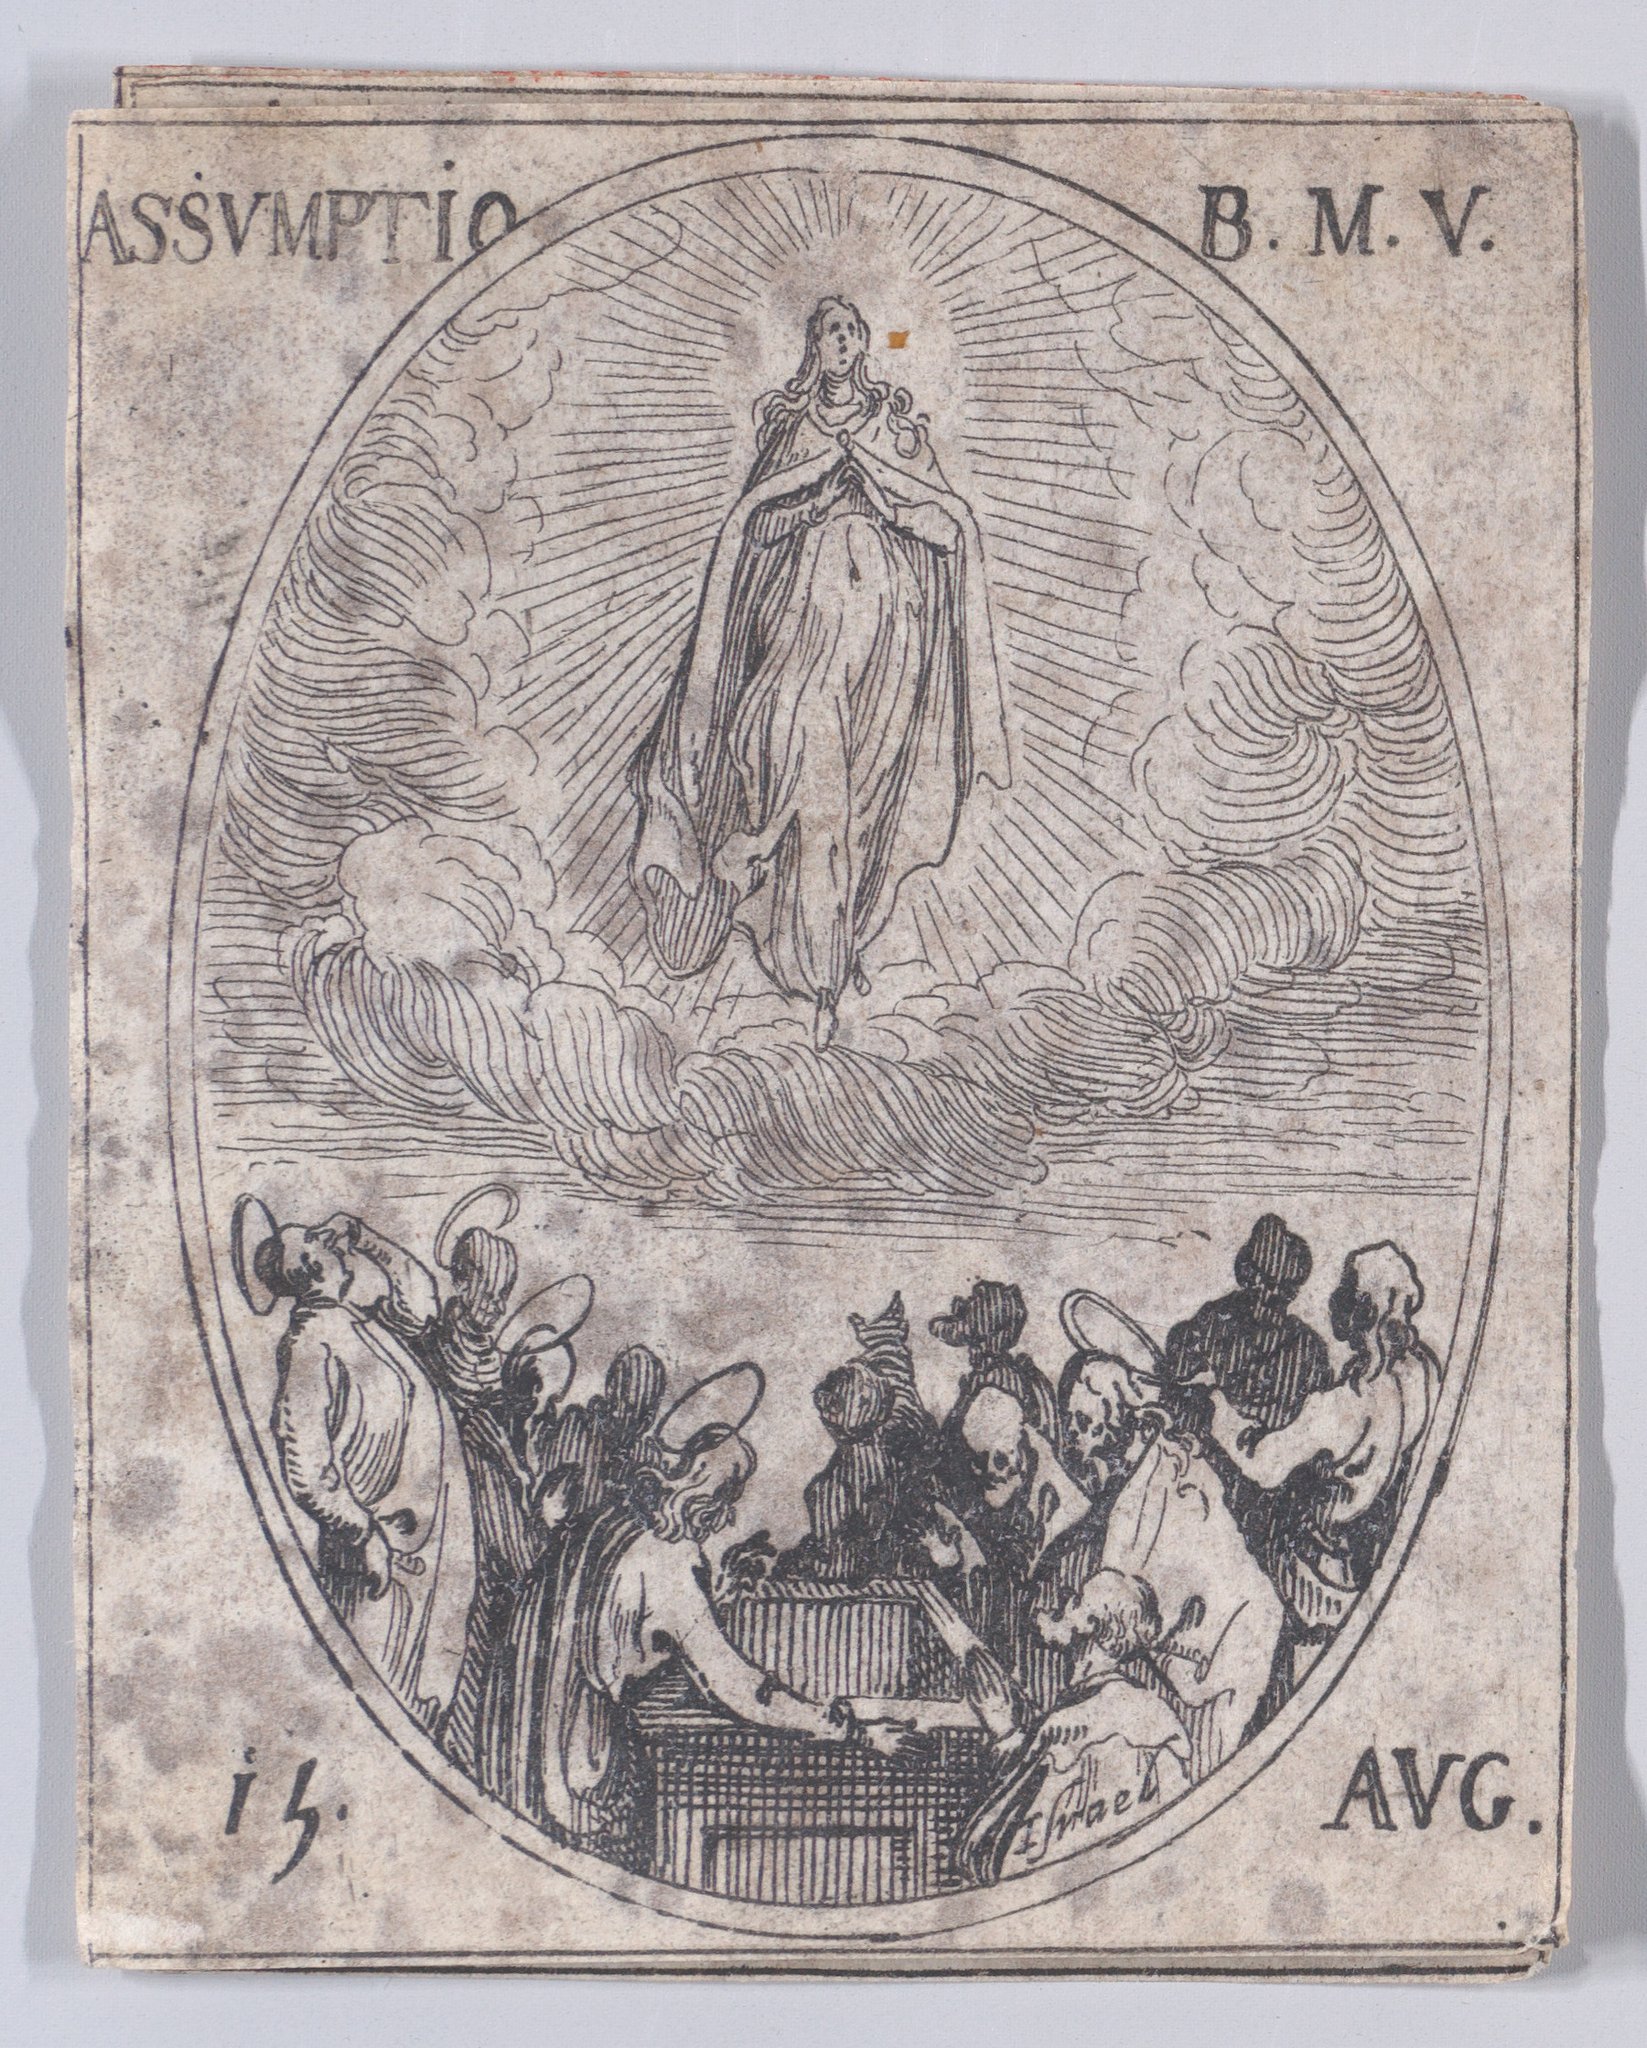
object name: print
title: L'Assomption de la Sainte Vierge (The Assumption of the Virgin), August 15th, from "Les Images De Tous Les Saincts et Saintes de L'Année" (Images of All of the Saints and Religious Events of the Year)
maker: jacques callot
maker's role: artist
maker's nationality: french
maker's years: 1592-1635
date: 1636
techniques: etching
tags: virgin mary,assumption of the virgin